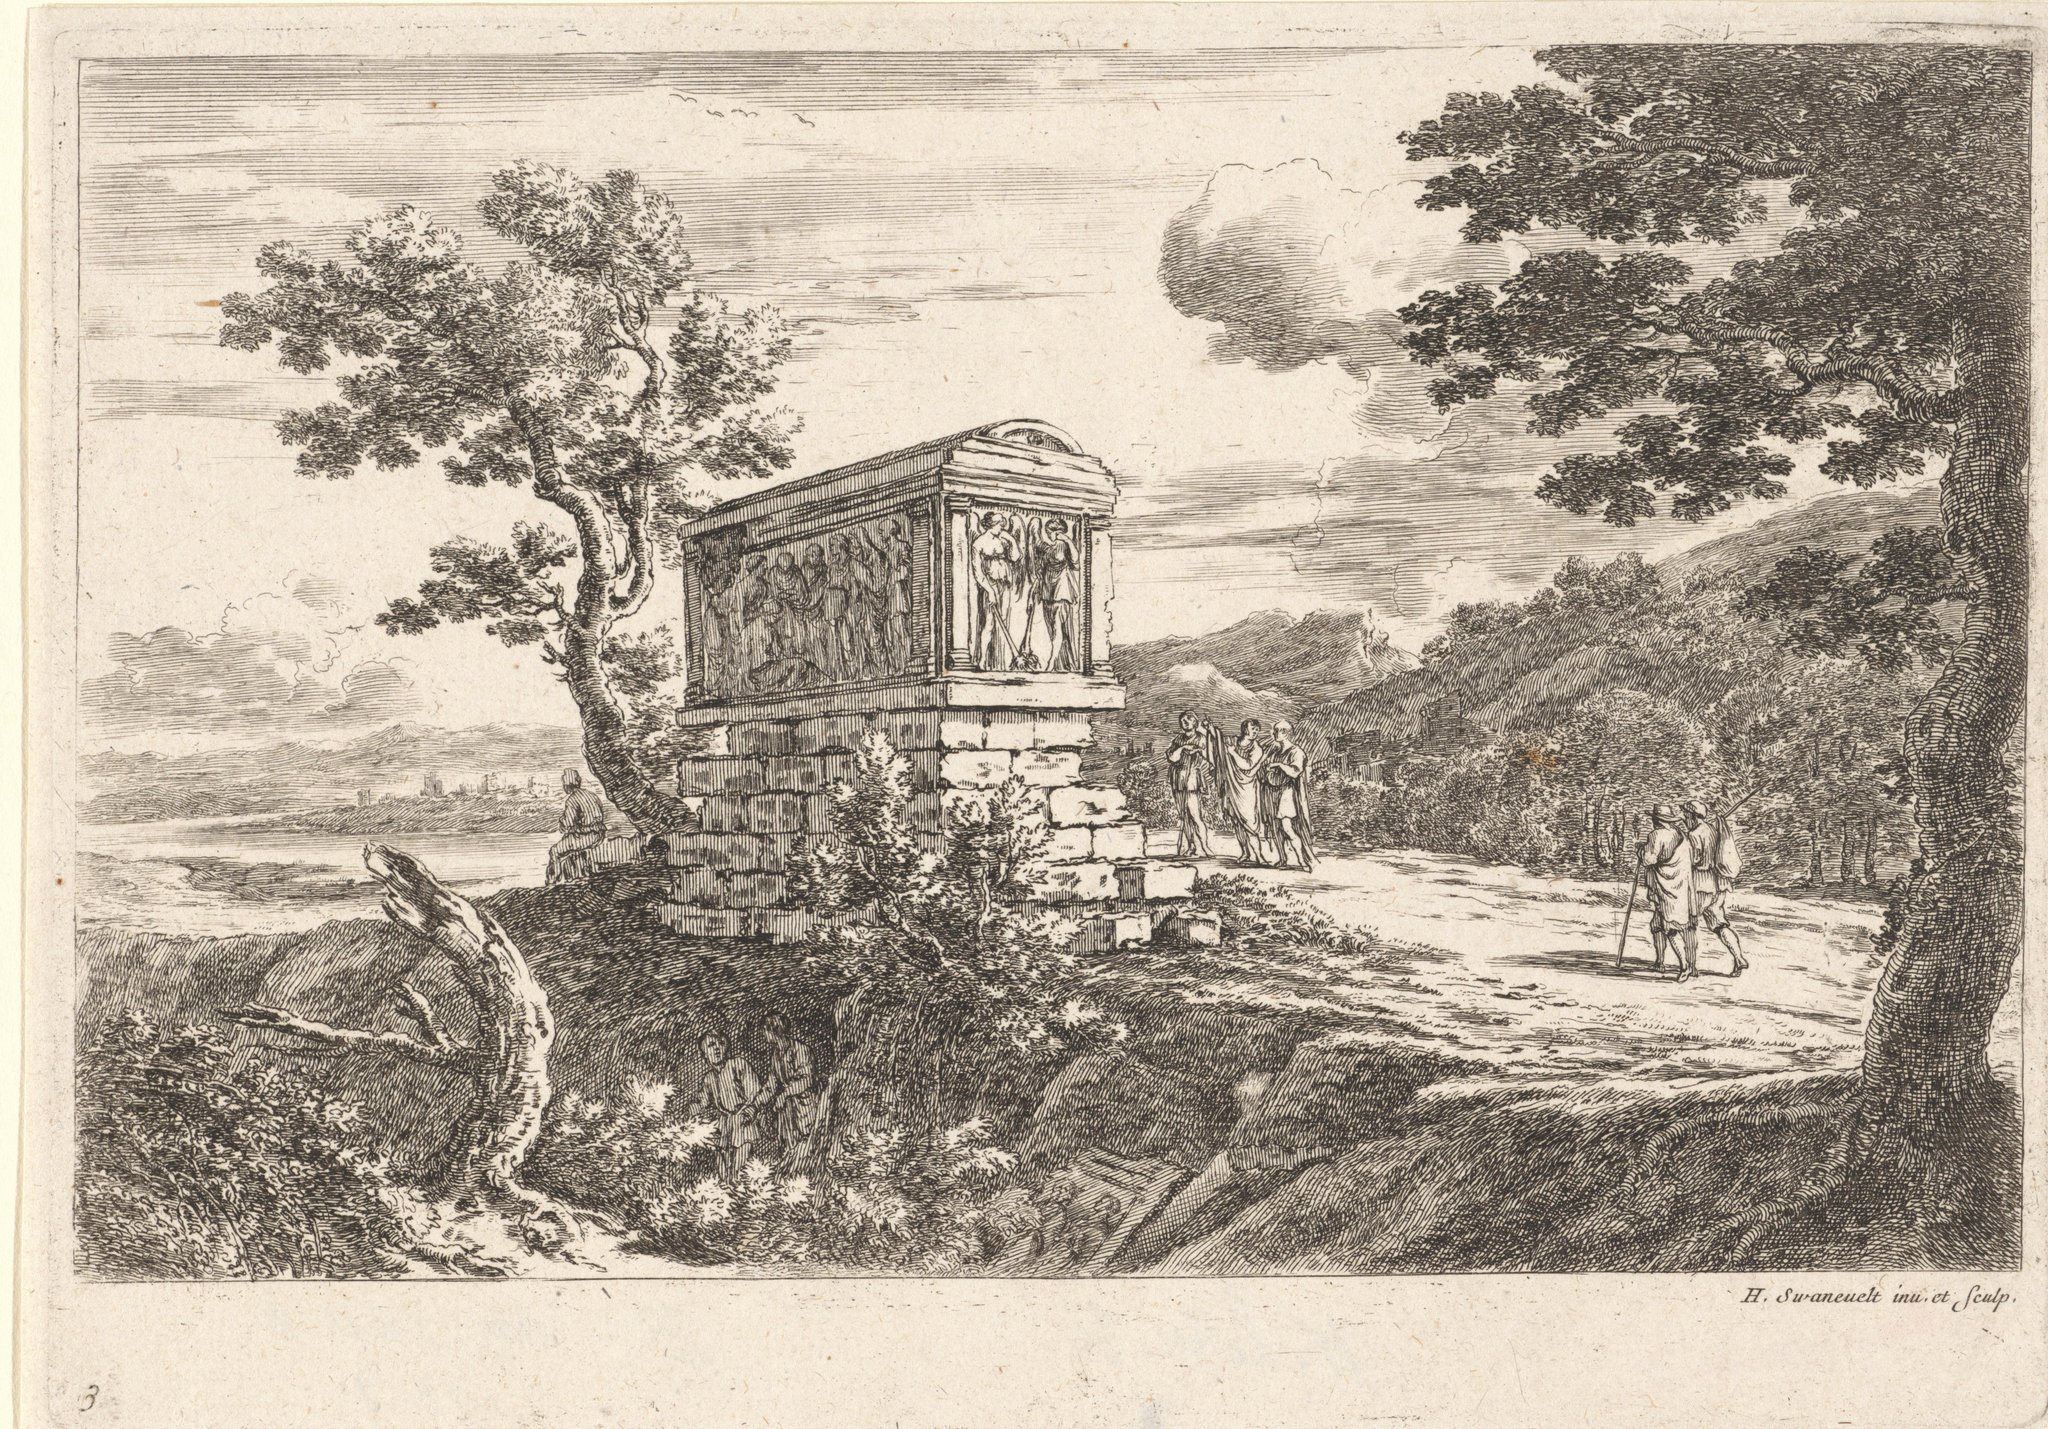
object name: print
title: Landschap met klassieke sarcofaag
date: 1633-1712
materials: paper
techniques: etching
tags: landscapes, sarcophagus, 'en route', traveller under way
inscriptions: collector's mark: Lugt 2228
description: In een landschap staat een klassieke sarcofaag met figuren in reliëf op een stenen verhoging. Rondom de sarcofaag bevinden zich enkele figuren.